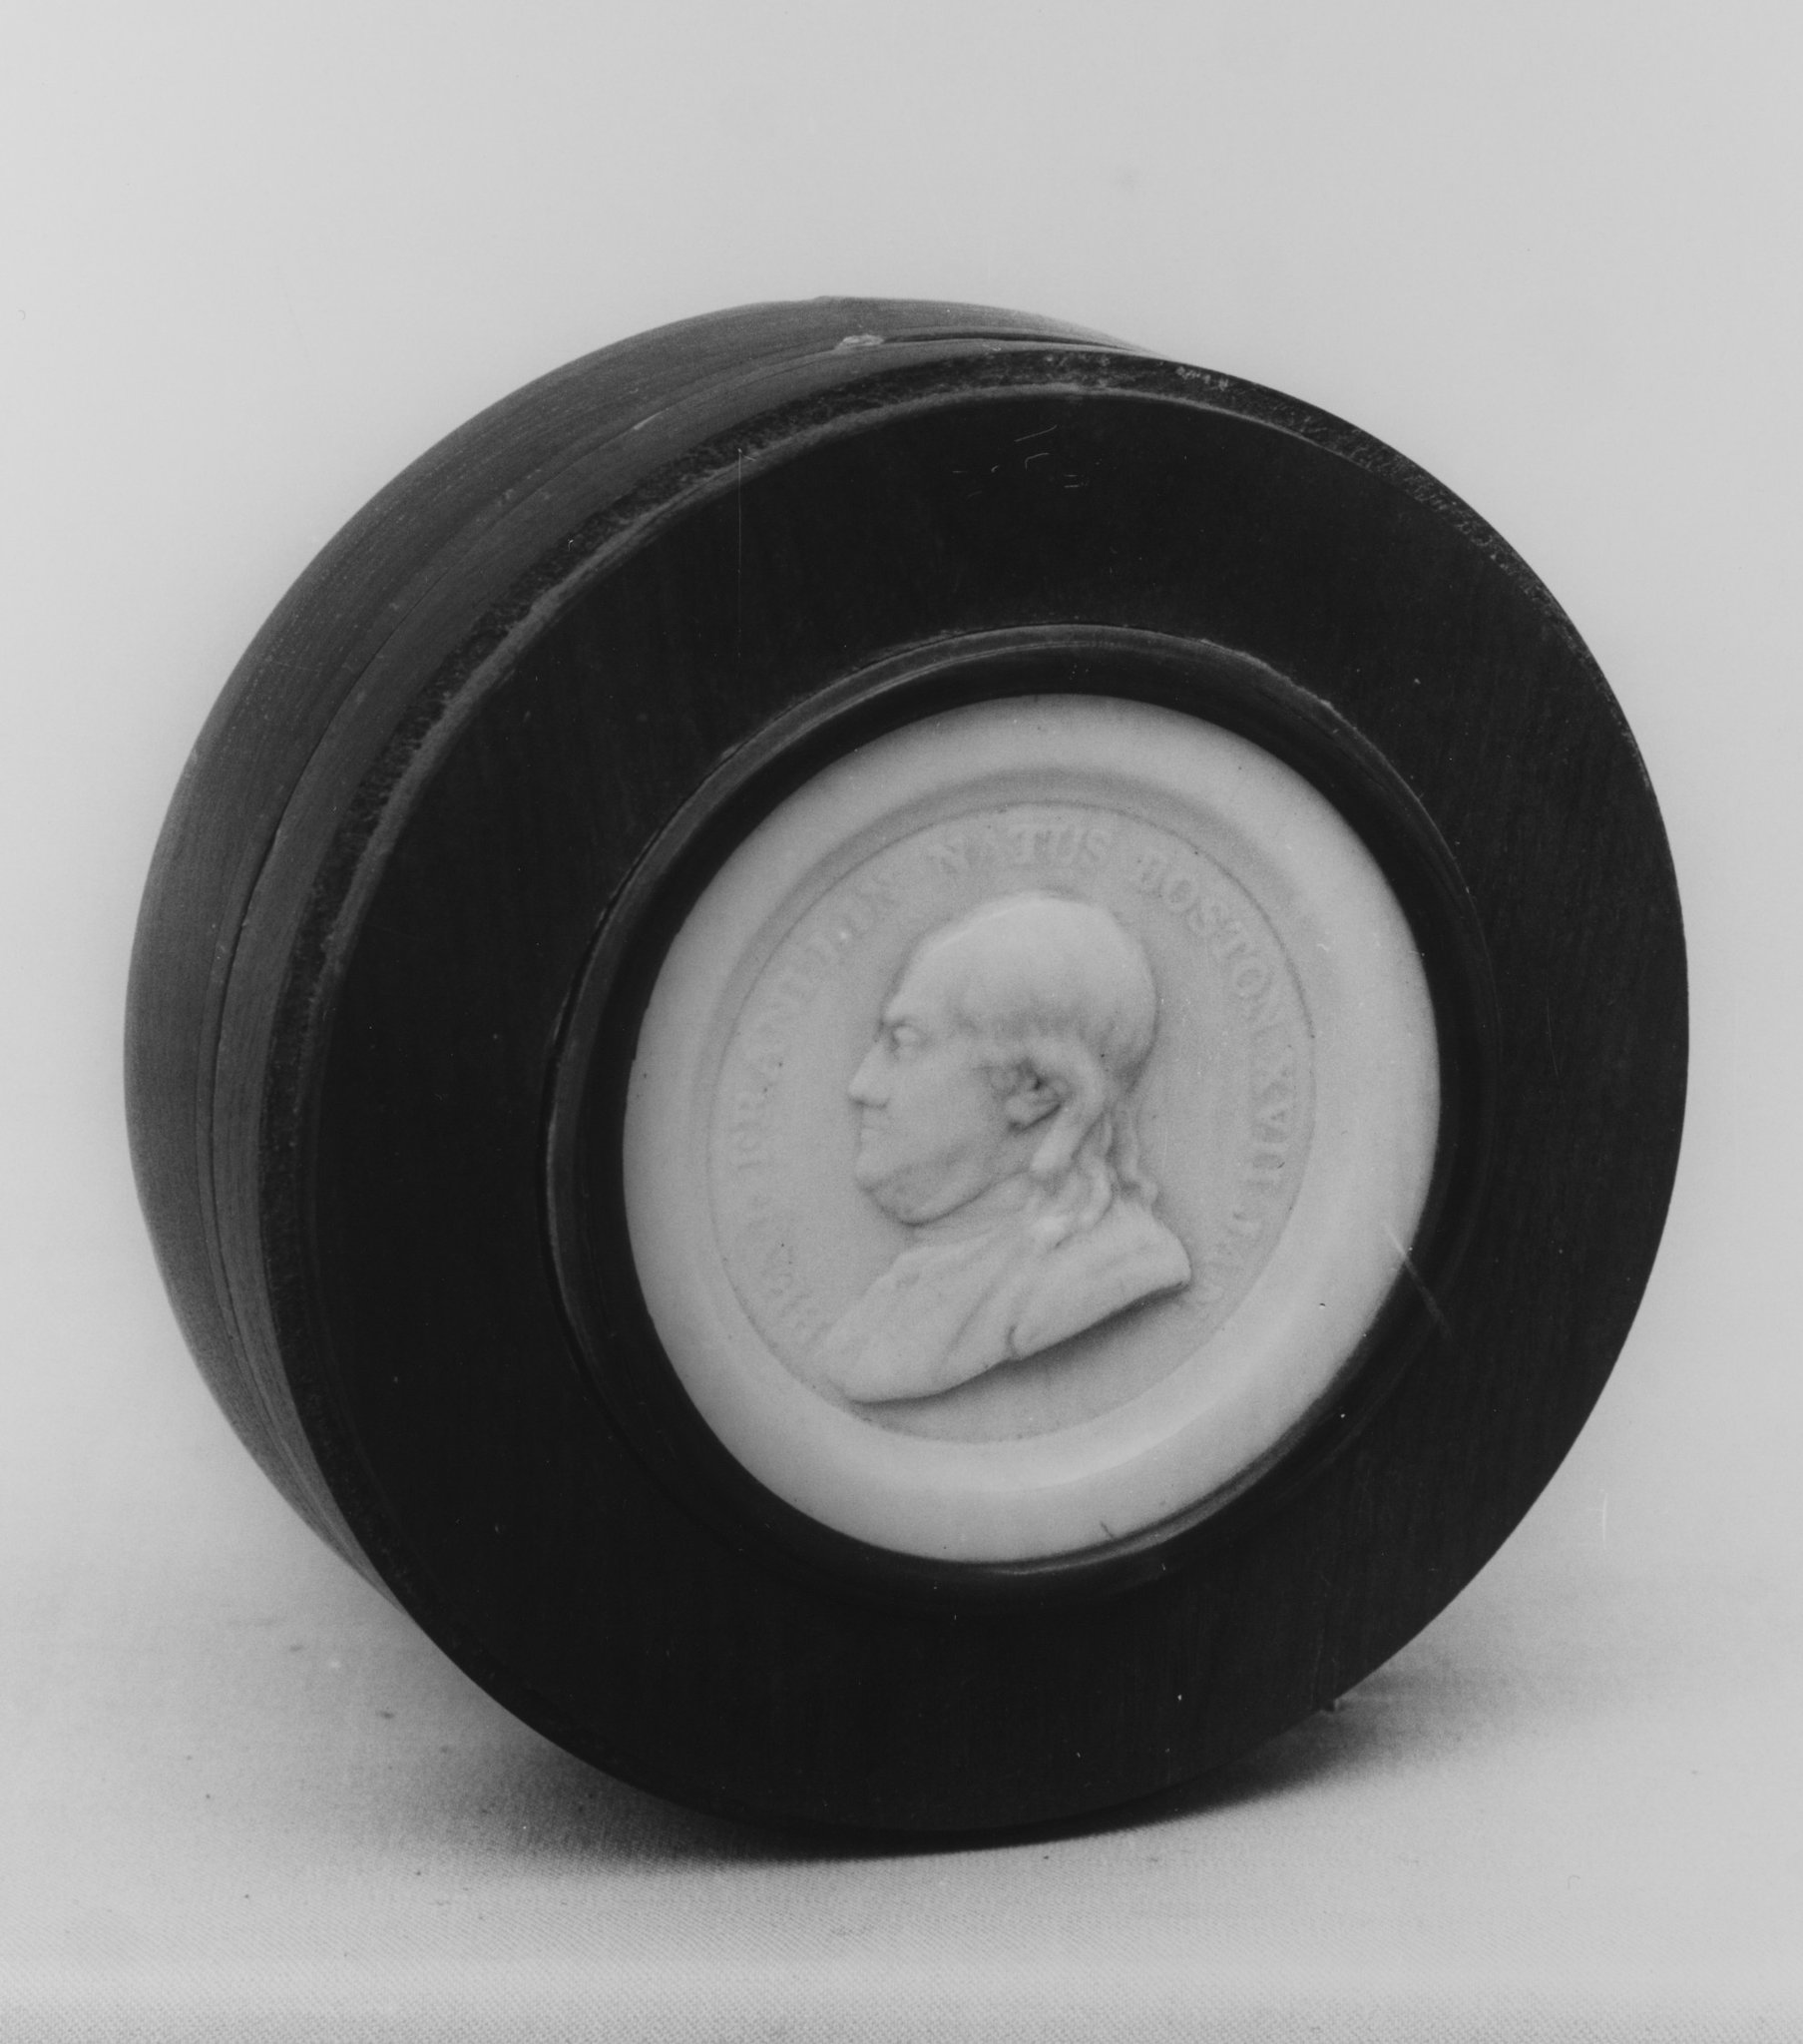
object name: box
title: Box with Medallion Top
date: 1800-1883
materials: horn, ivory, wood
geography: france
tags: benjamin franklin,men